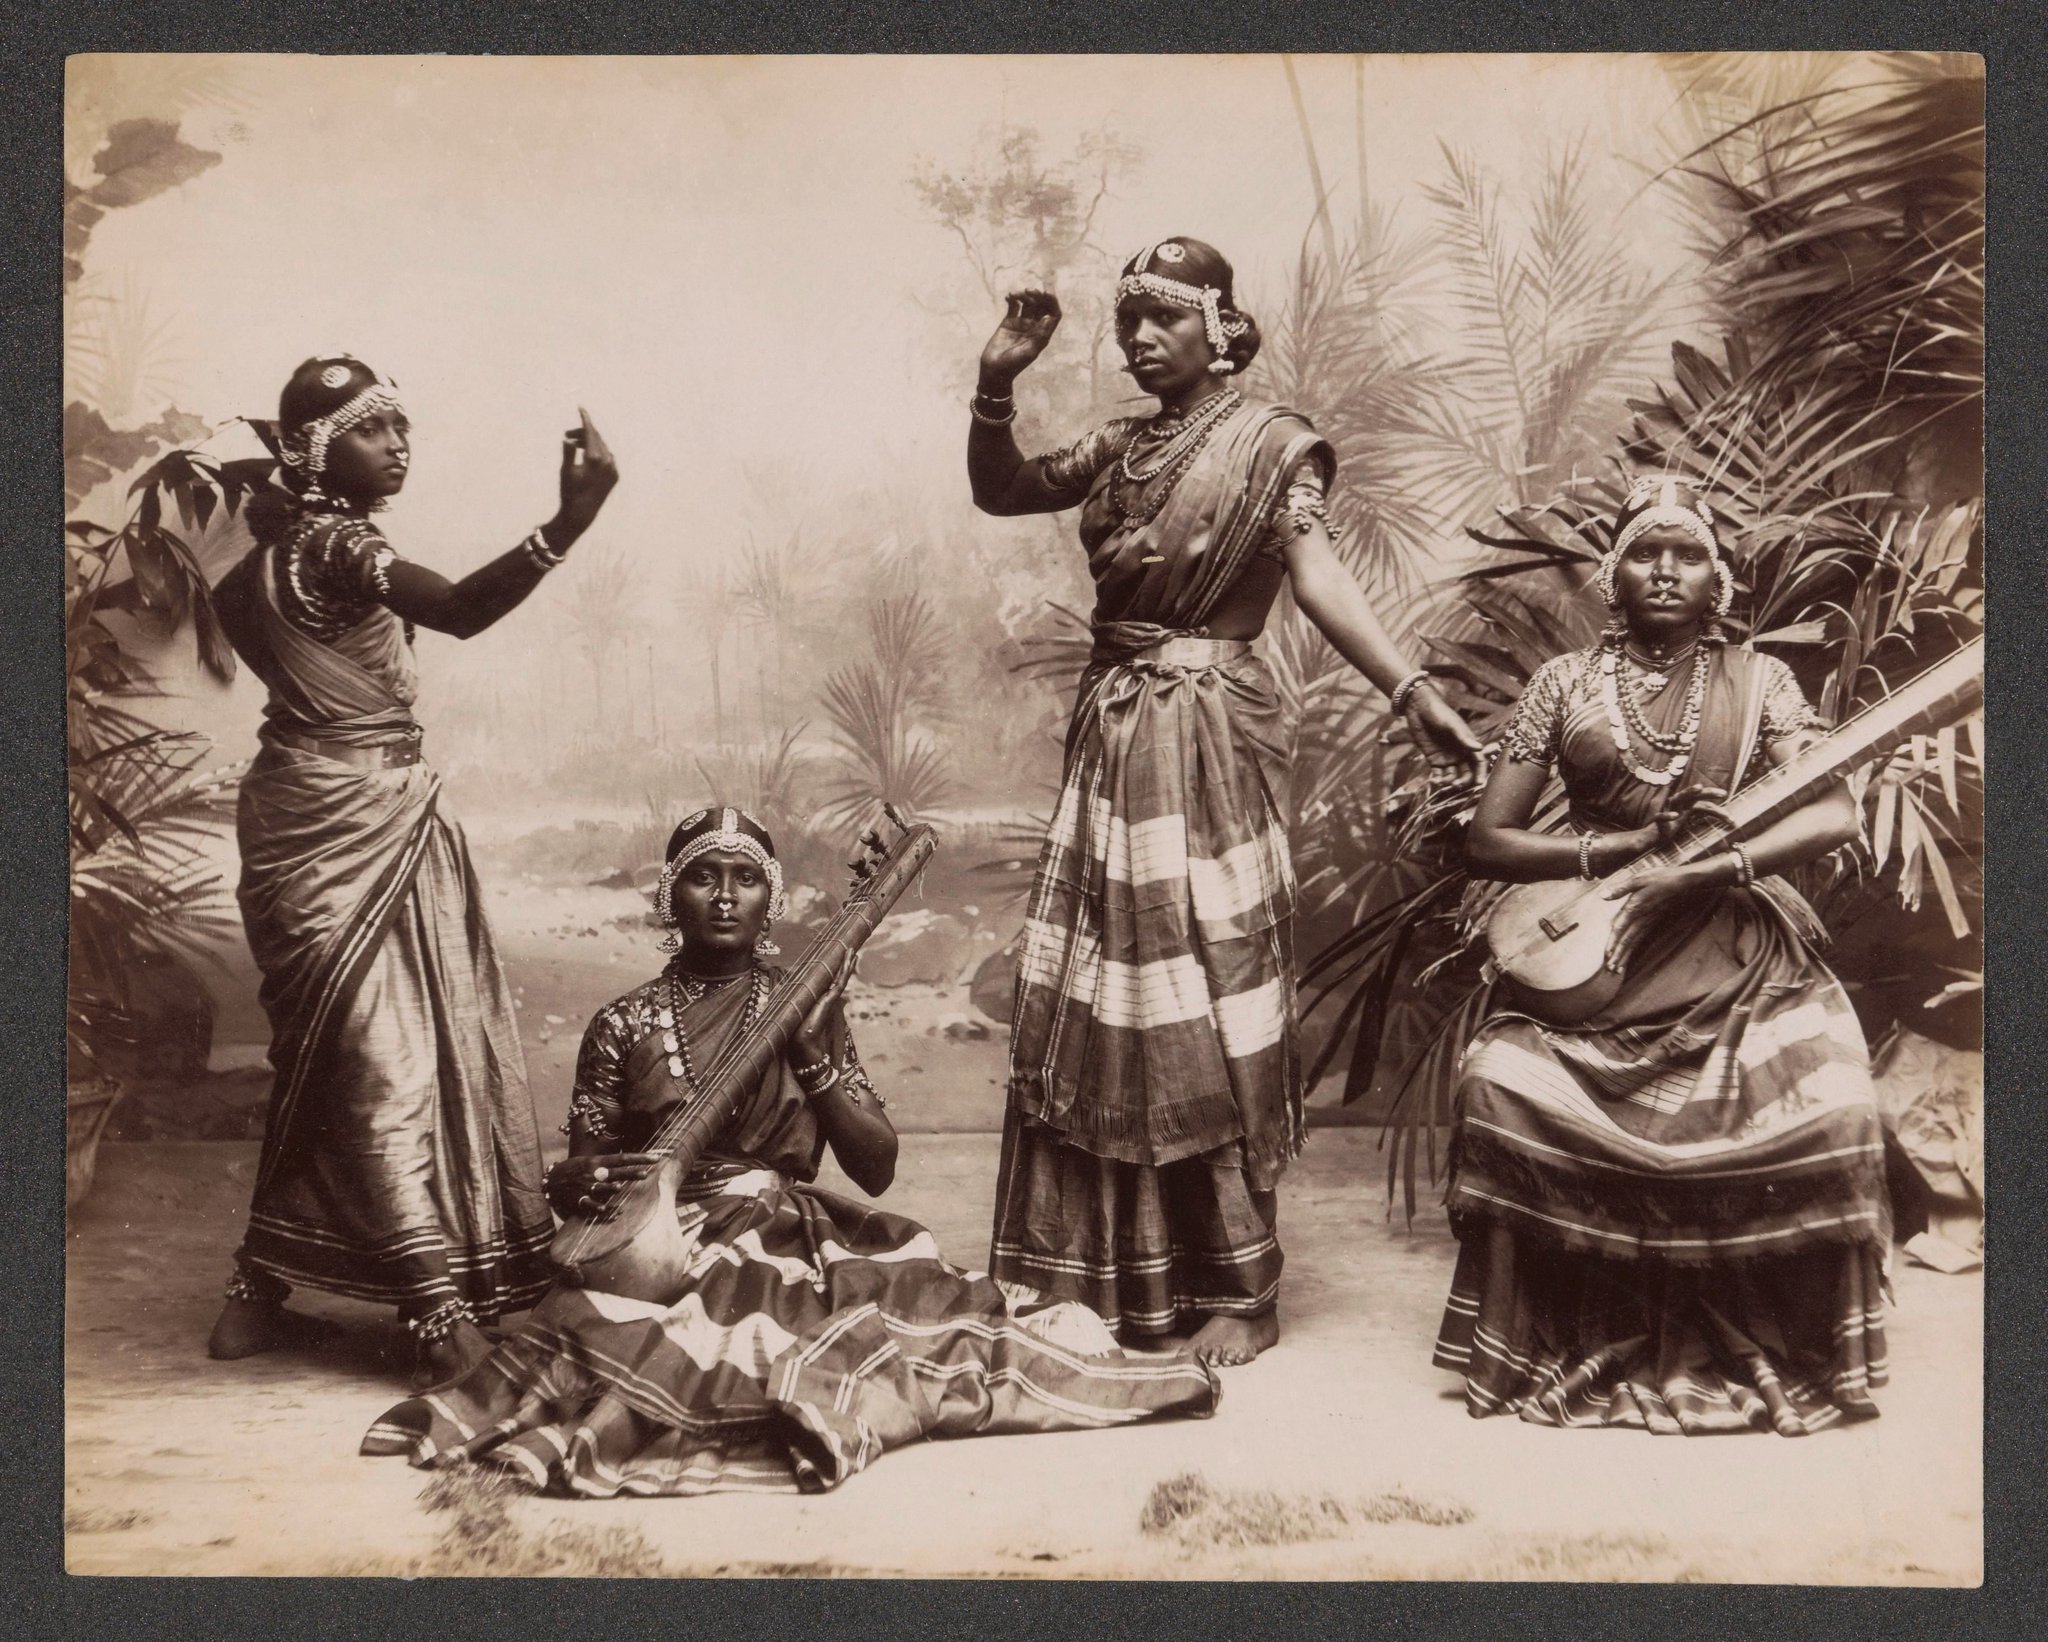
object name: photograph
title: Studio portrait of unknown dancers and musicians, Sri Lanka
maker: Anonymous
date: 1870-1900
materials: paper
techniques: albumen print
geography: sri lanka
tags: musician, historical persons not known by name - bb - woman, ballet group; dancers on the stage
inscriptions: inscription: ‘Dansmeisjes/ op/ Ceylon.’